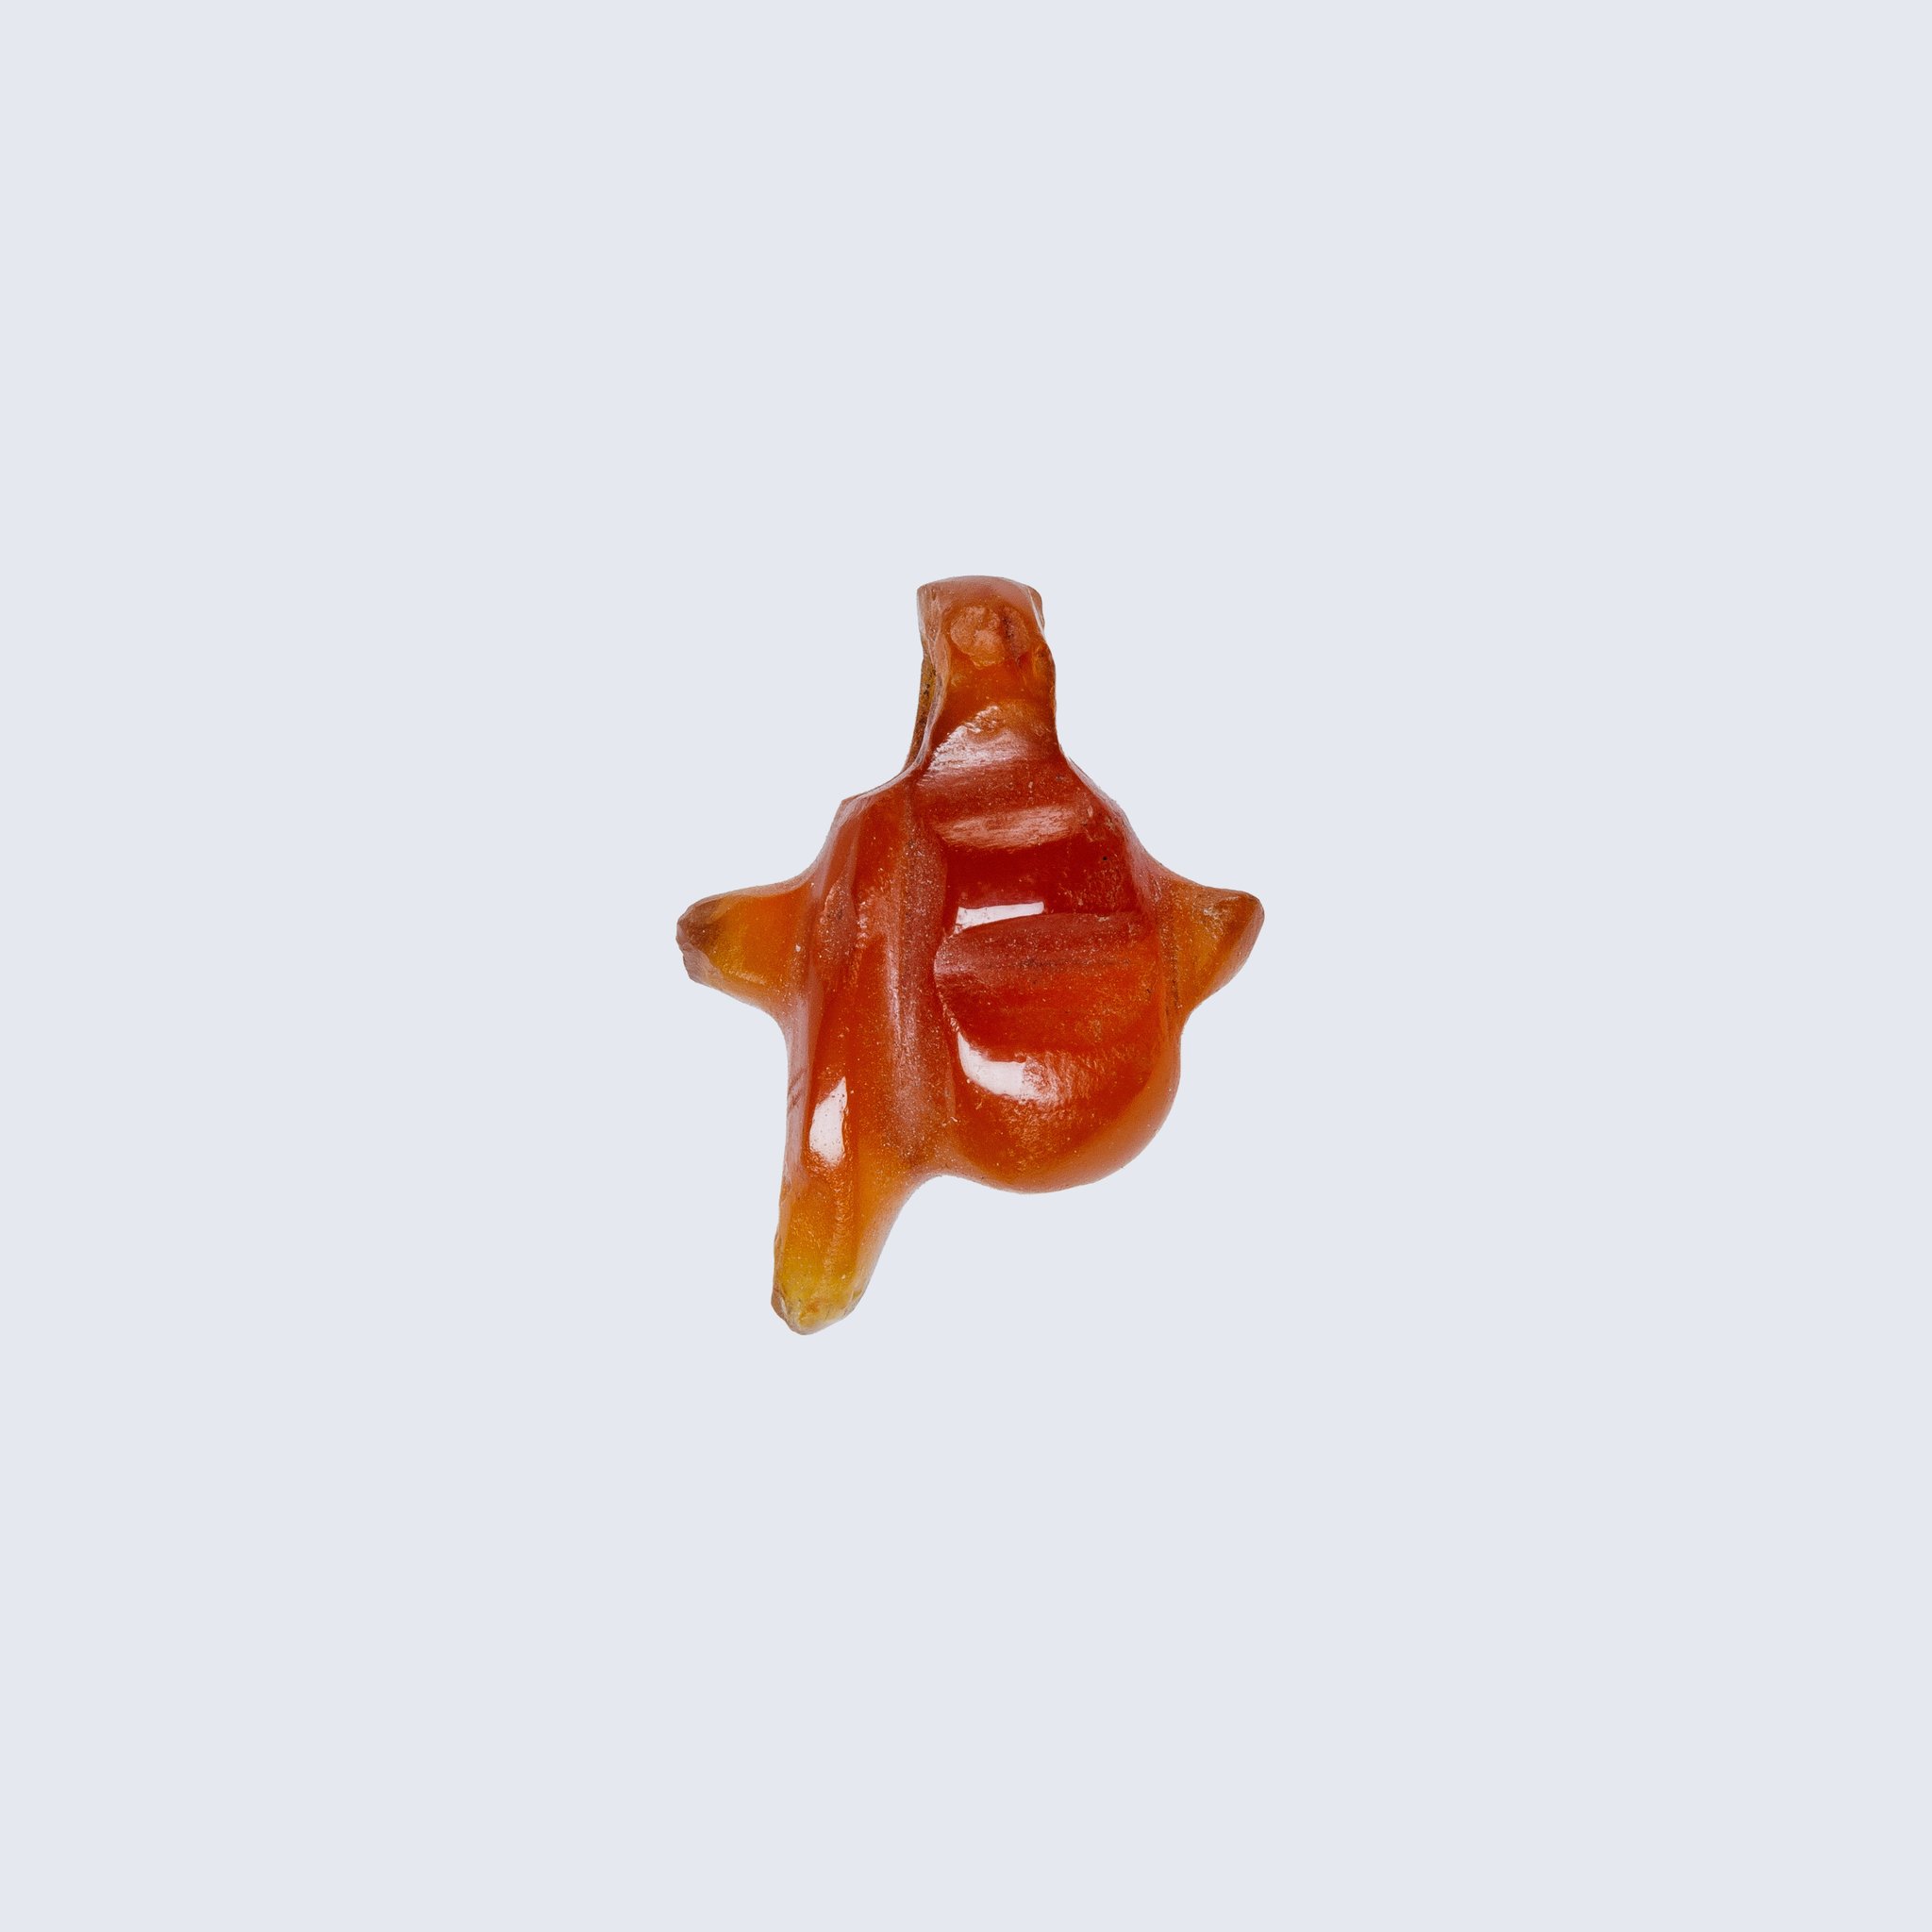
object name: amulet, bundle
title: Bundle amulet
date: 2150-1950 BCE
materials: gemstone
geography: southern upper egypt